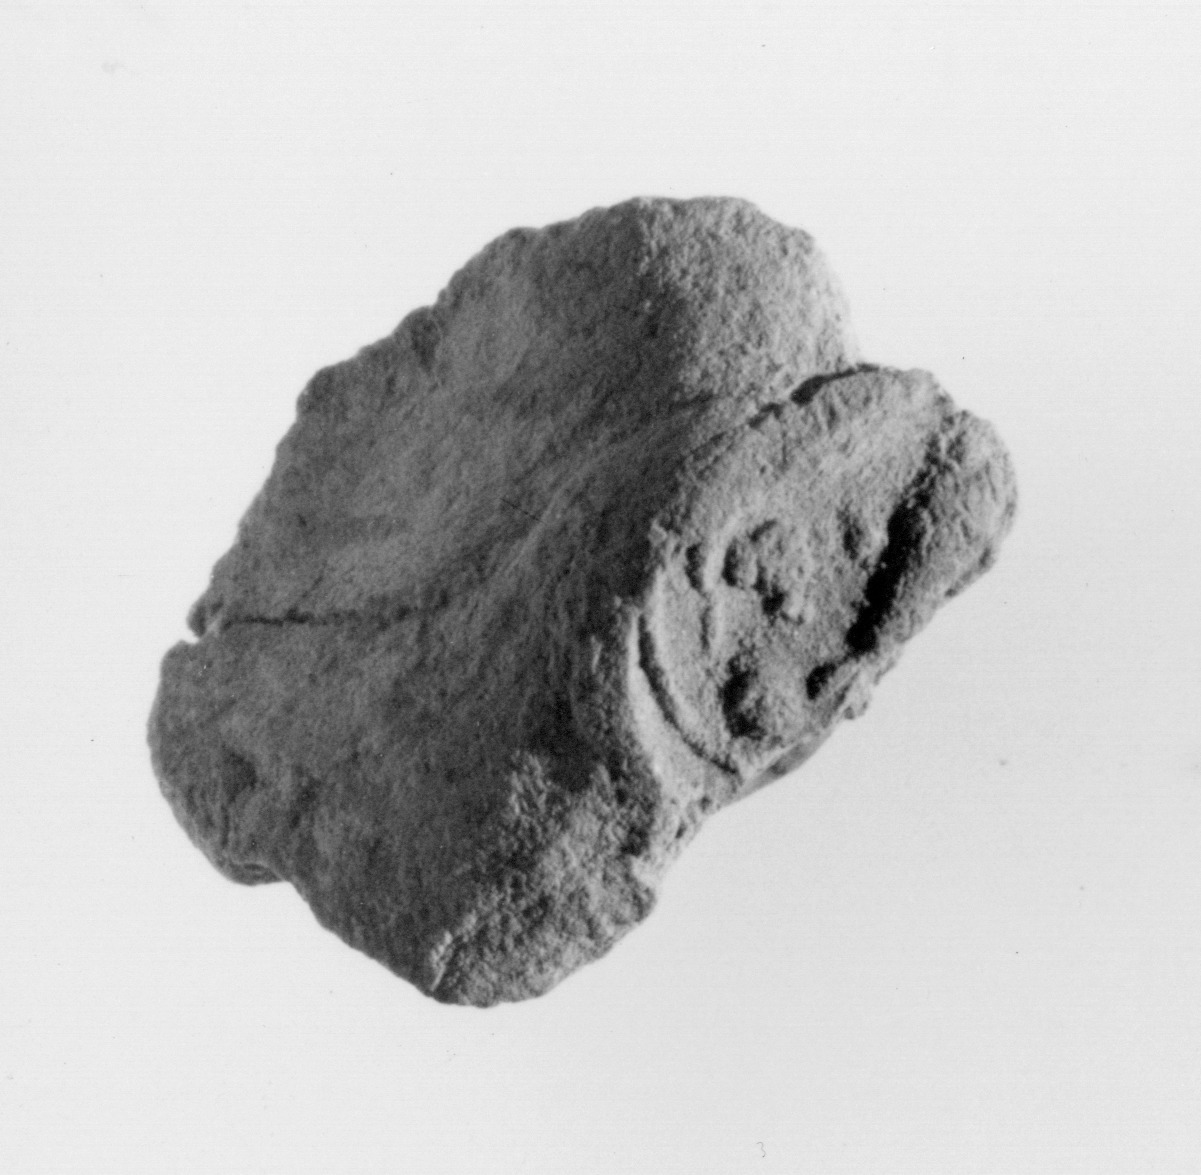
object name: sealing, falcon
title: Document Sealing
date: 1390-1352 BCE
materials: mud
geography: egypt